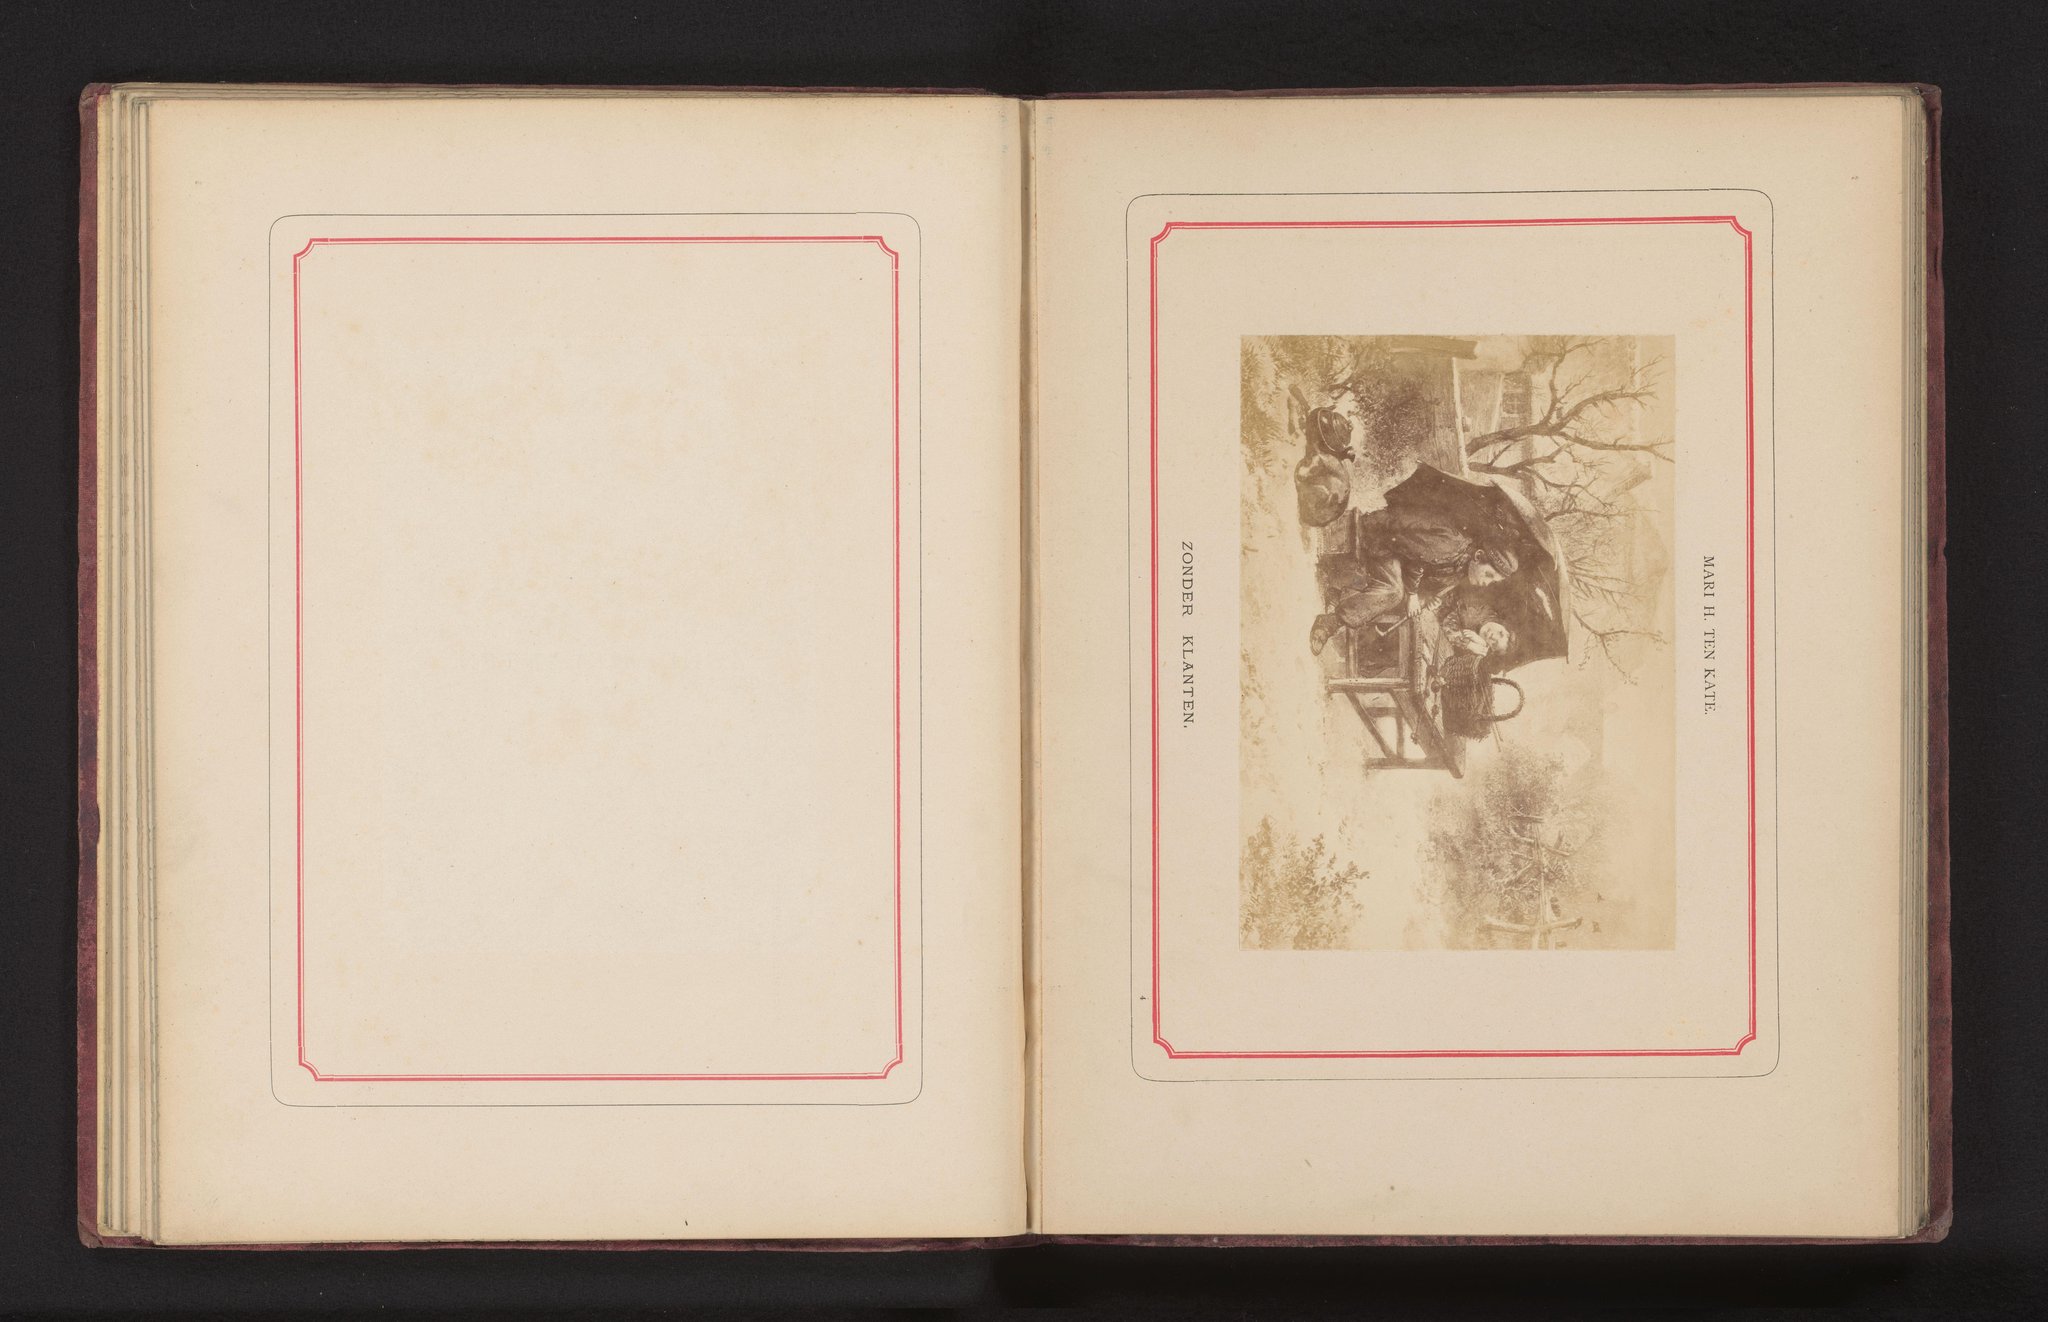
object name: photograph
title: Fotoreproductie van een schilderij, voorstellende twee kinderen met een paraplu achter een kraam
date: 1868-1878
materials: photographic support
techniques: albumen print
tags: child, stall, booth (~ market), umbrella